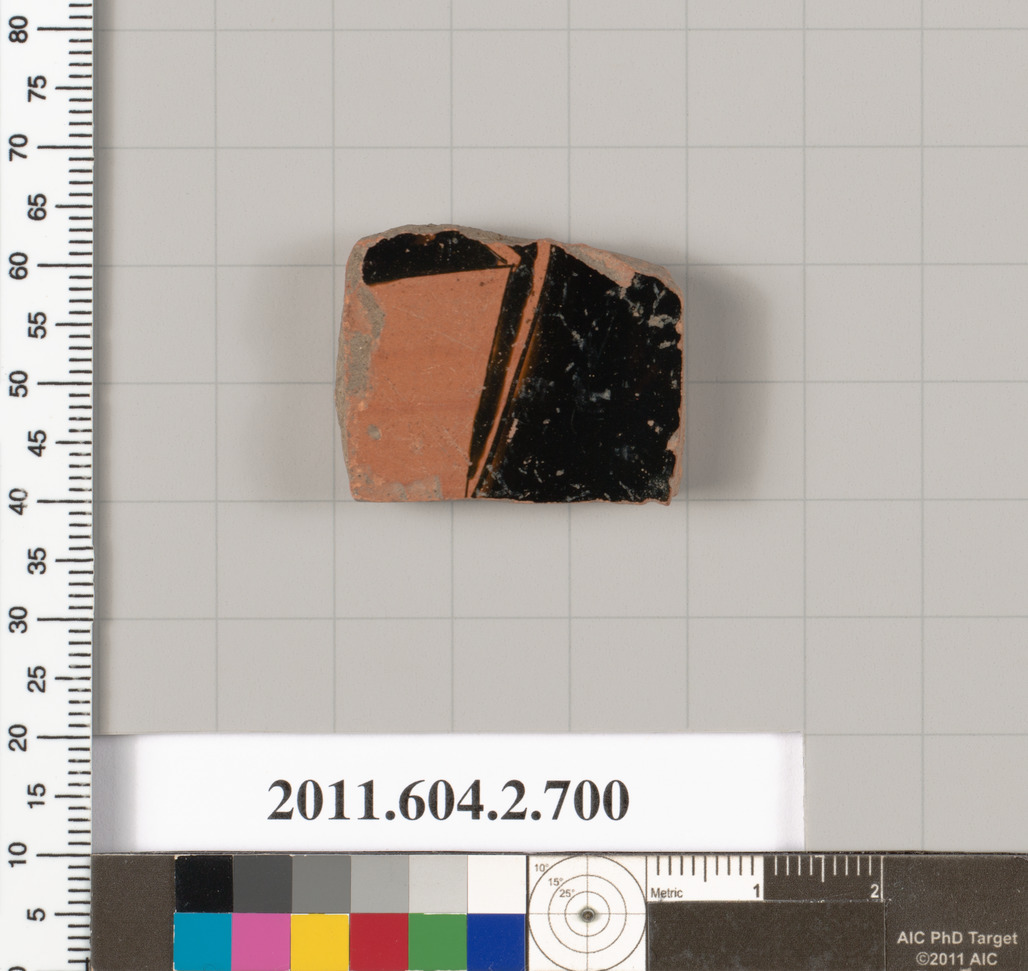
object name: calyx krater fragment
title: Terracotta fragment of a calyx-krater (bowl for mixing wine and water)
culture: greek, attic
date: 490-470 BCE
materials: terracotta